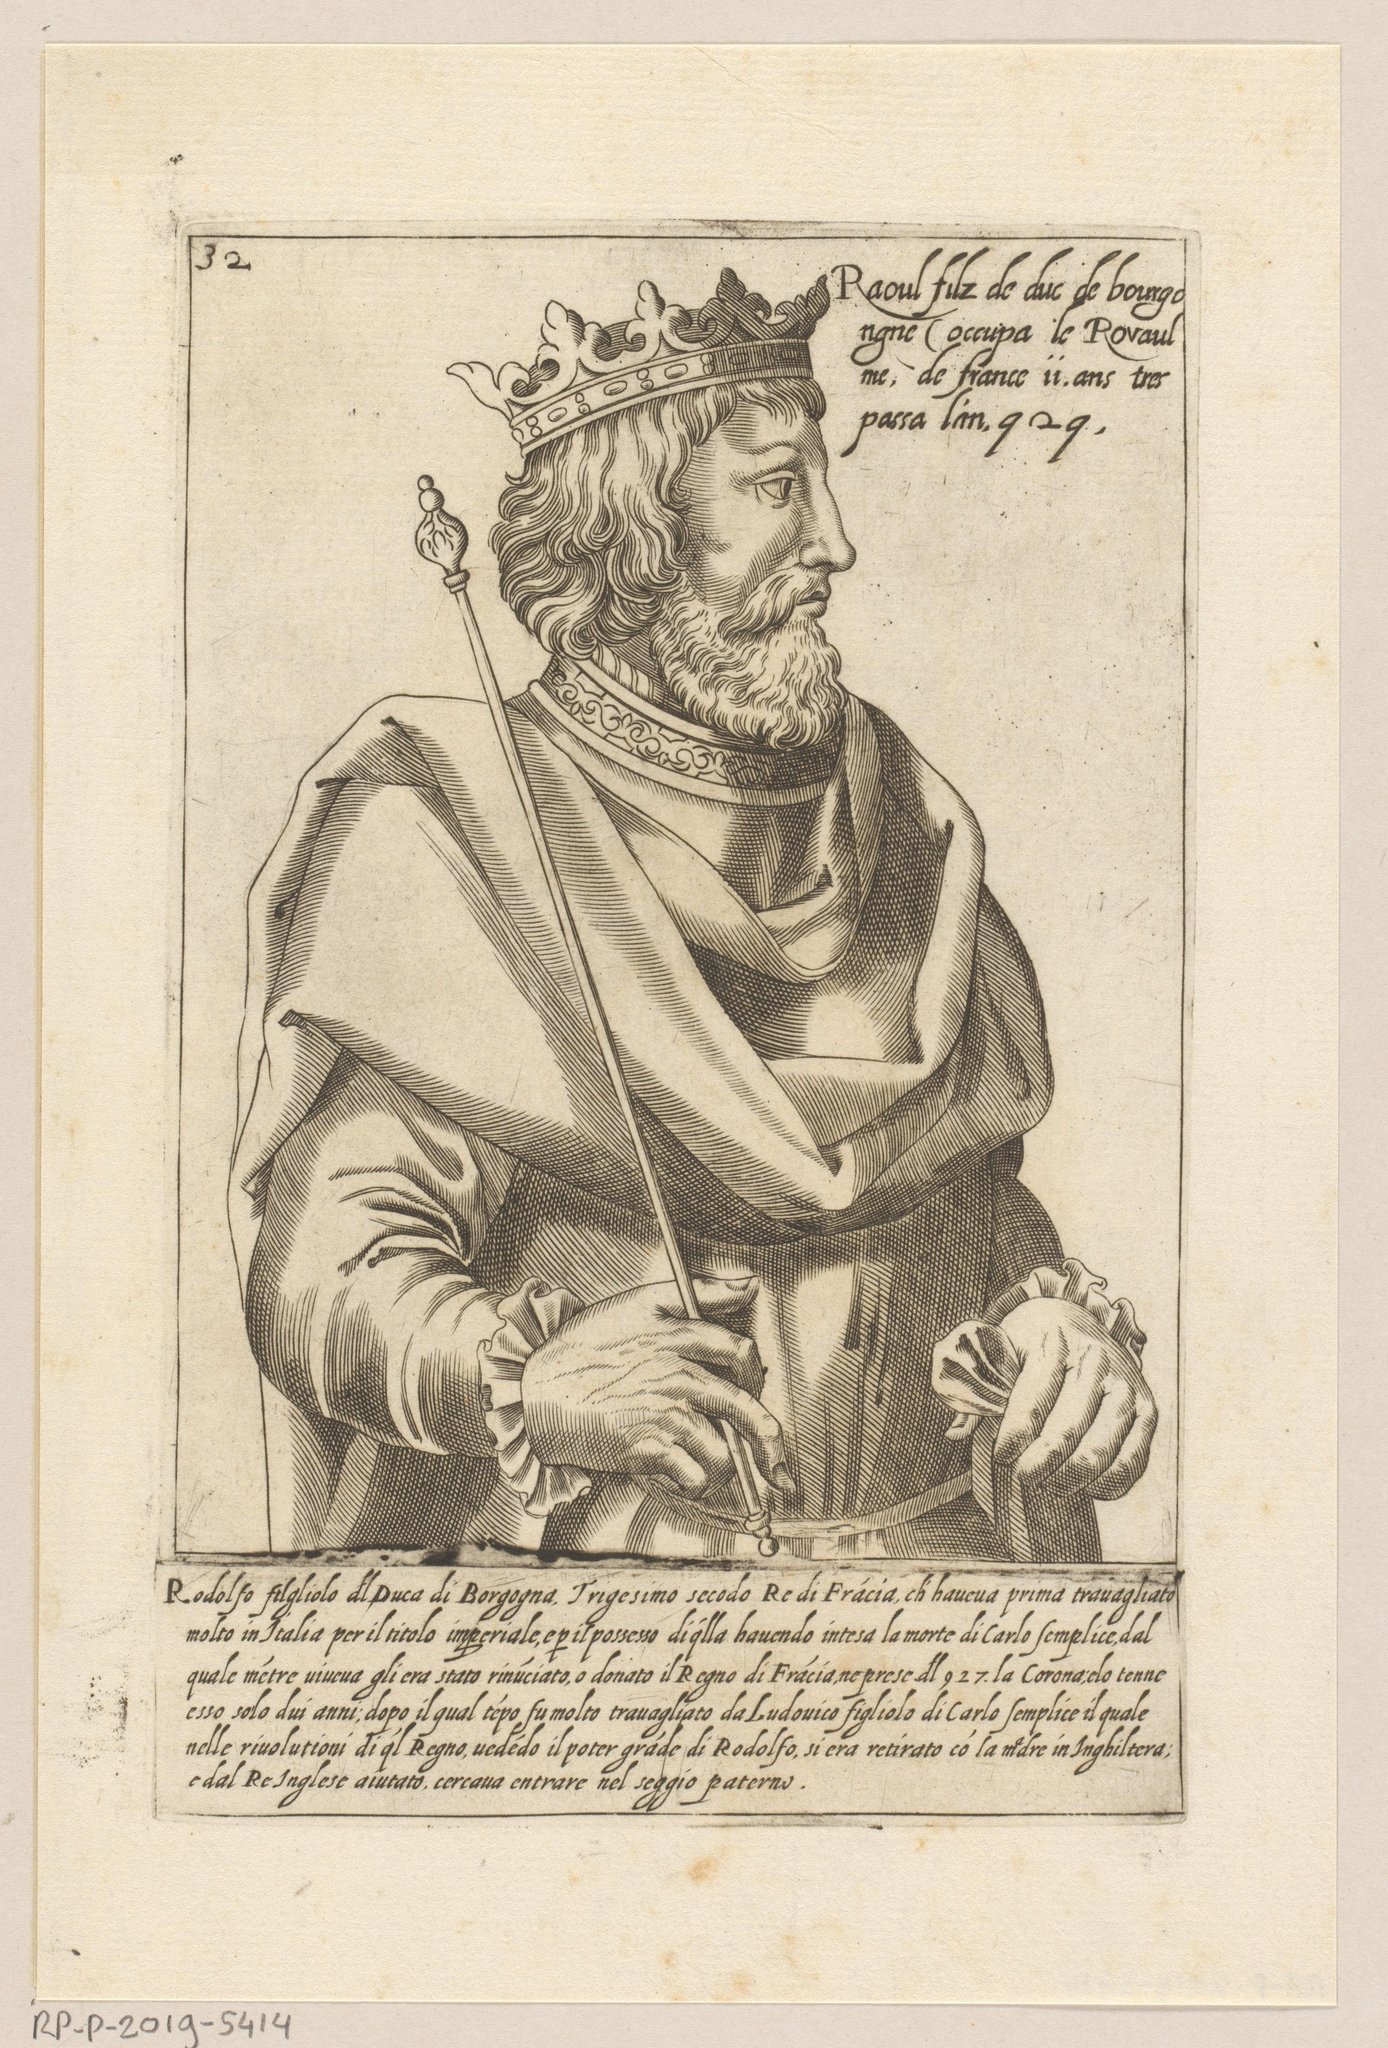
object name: print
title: Portret van Rudolf van Frankrijk, koning van West-Francië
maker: Anonymous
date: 1588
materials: paper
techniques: engraving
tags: crown (symbol of sovereignty), sceptre, staff (symbol of sovereignty), historical persons, king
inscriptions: watermark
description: Prent voor het eerst gebruikt in: Cronica Breve de i fatti illustri de're di Francia, con le loro effigie dal naturale cominciando da Faramondo (...). Venetië: Bernardo Giunti, 1588. Prent in ieder geval ook gebruikt in de editie van 1590 en mogelijk ook in een Franse uitgave van 1597.